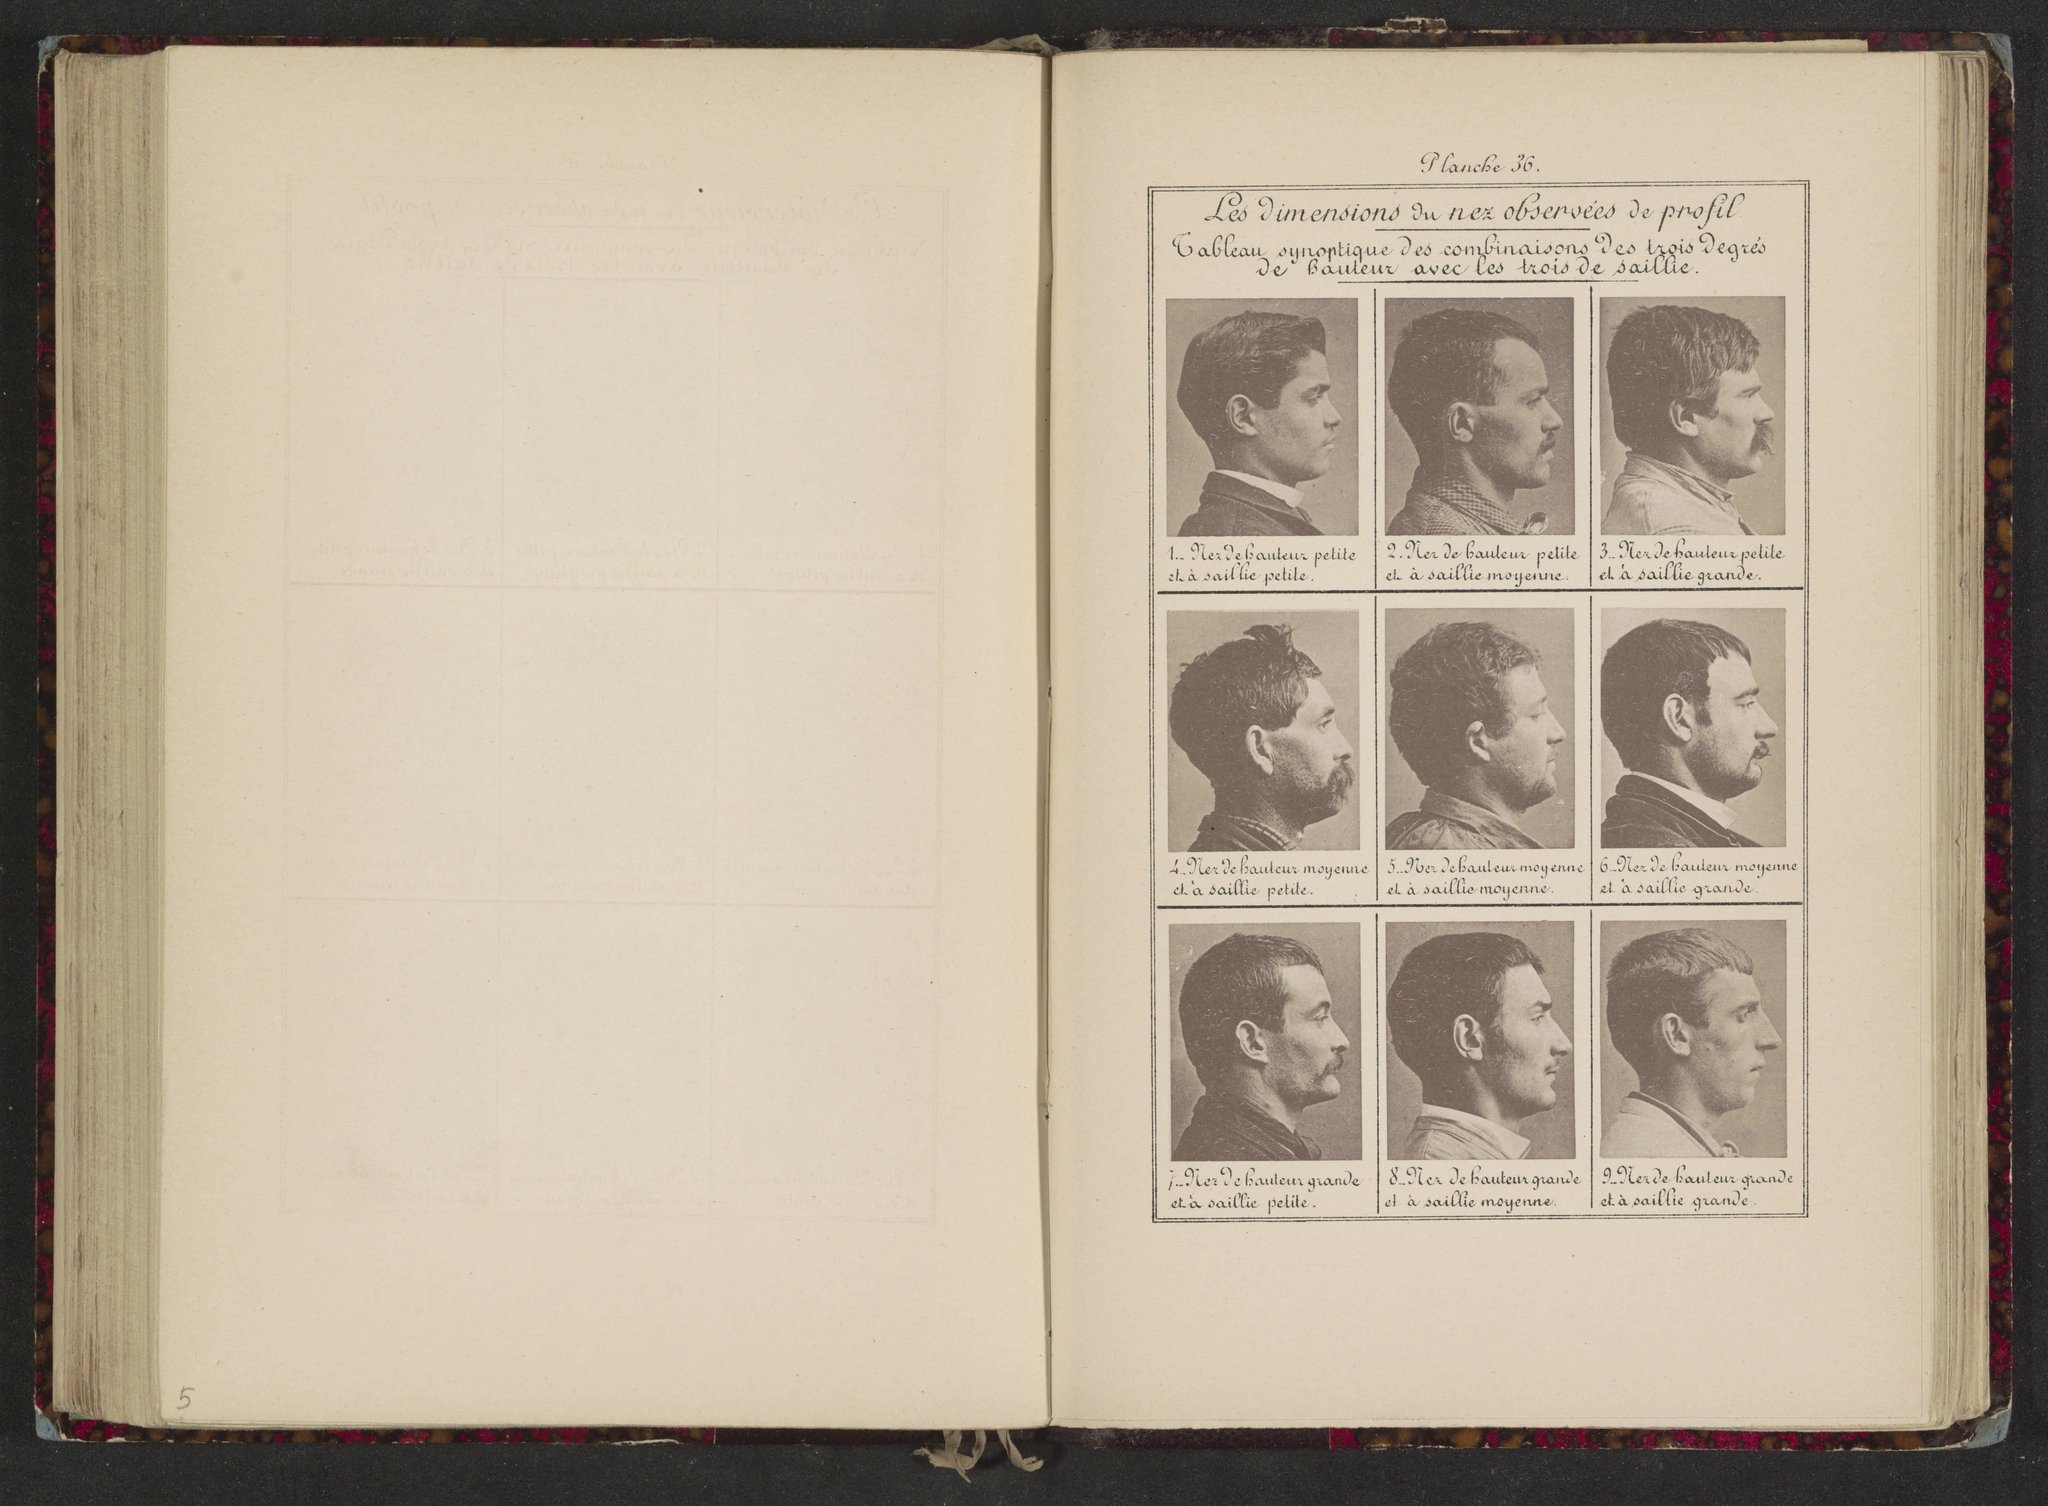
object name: page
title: Les dimensions du nez observées de profil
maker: Anonymous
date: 1880-1893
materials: paper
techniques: photograph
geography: france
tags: head (human) (+ sideview, profile), parts of the face: nose, france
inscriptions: number: ‘Planche 36.’, inscription: ‘Nez de hauteur petite et à saillie petite. (...) Nez de hauteur grande et à saillie grande.’, number: ‘1. (...) 9.’, inscription: ‘Tableau synoptique des combinaisons des trois degrés de hauteur avec les trois de saillie.’